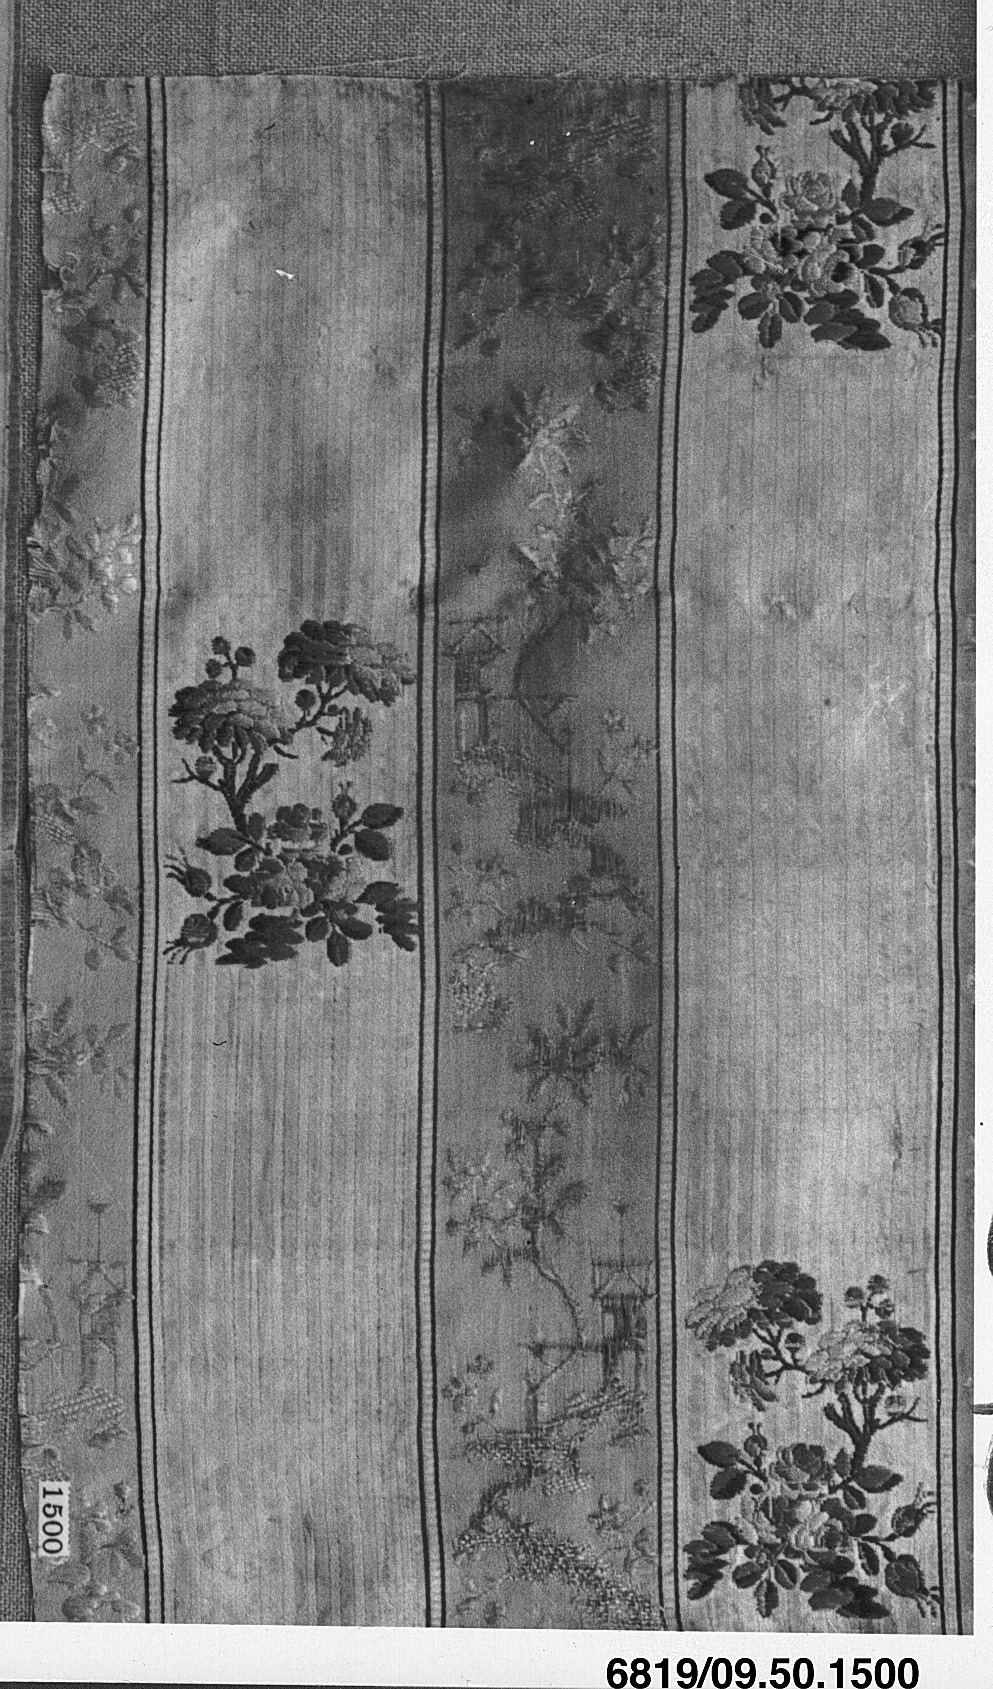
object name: piece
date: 1767-1800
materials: silk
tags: flowers,leaves